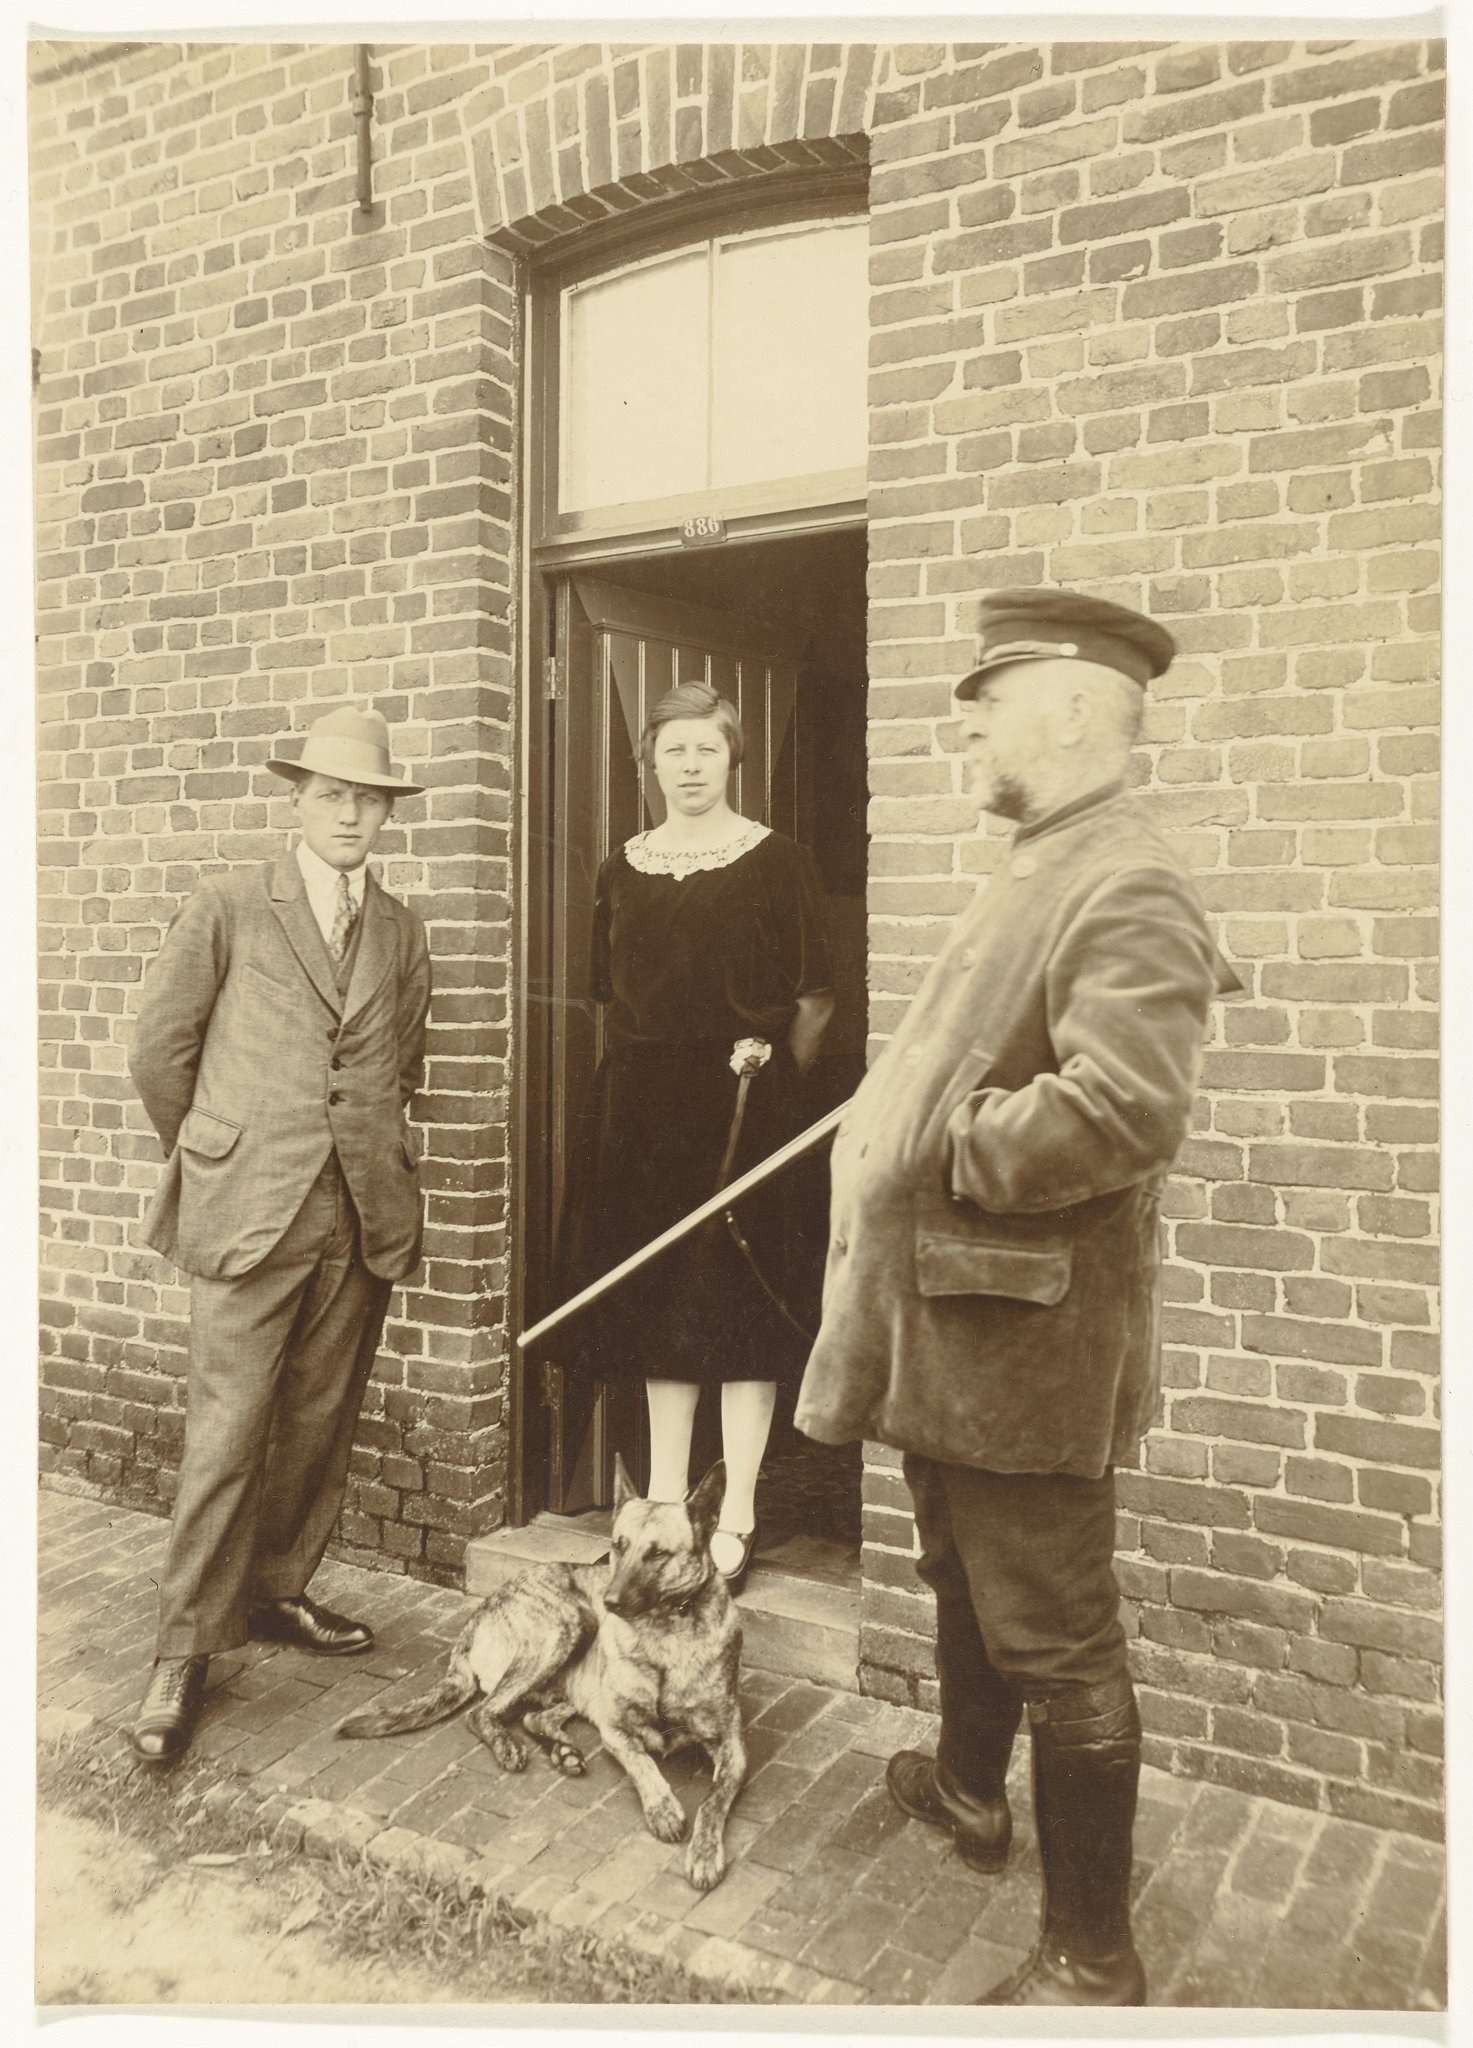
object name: photograph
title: Portret van een drietal in een deuropening met een hond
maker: richard tepe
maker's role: fotograaf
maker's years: 1864-1952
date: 1900-1930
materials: paper, photographic support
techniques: gelatin silver print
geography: netherlands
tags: dog